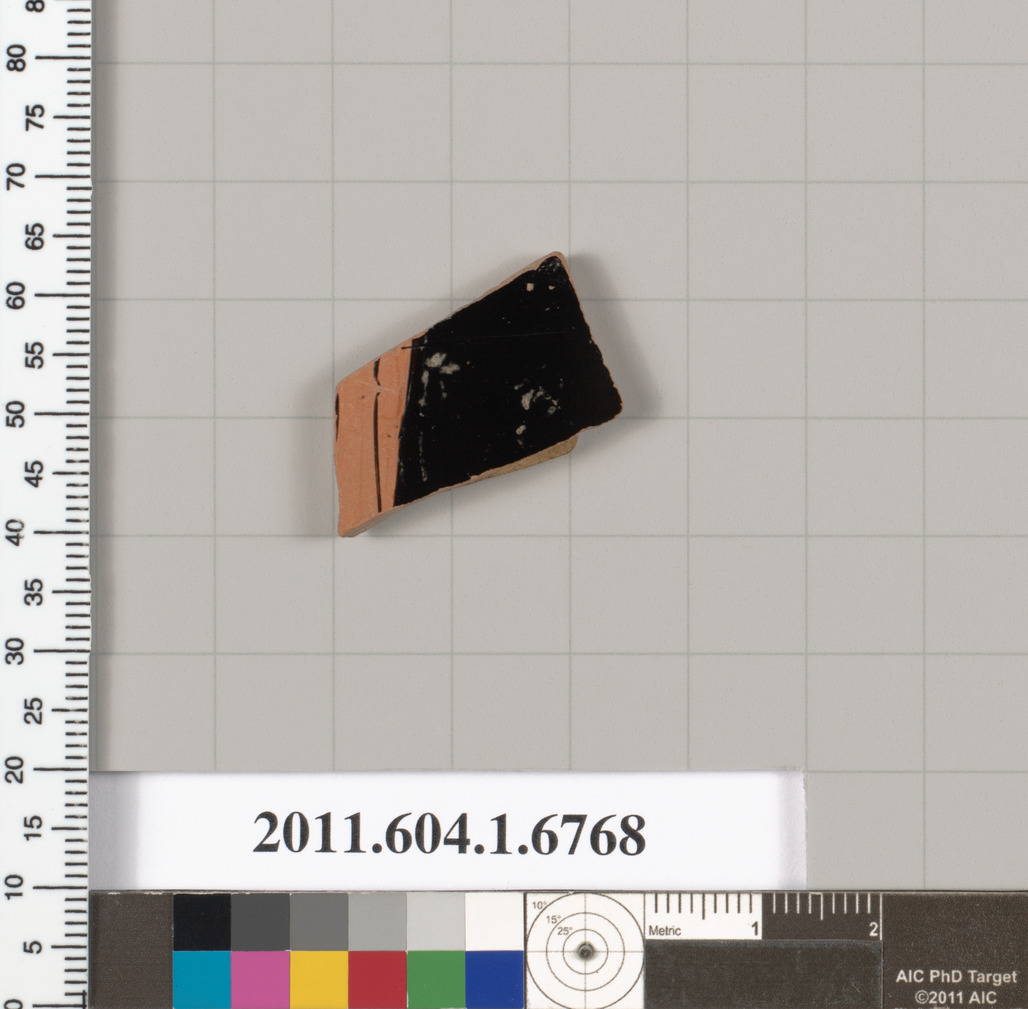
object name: kylix fragment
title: Terracotta fragment of a kylix (drinking cup)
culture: greek, attic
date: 490-470 BCE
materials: terracotta